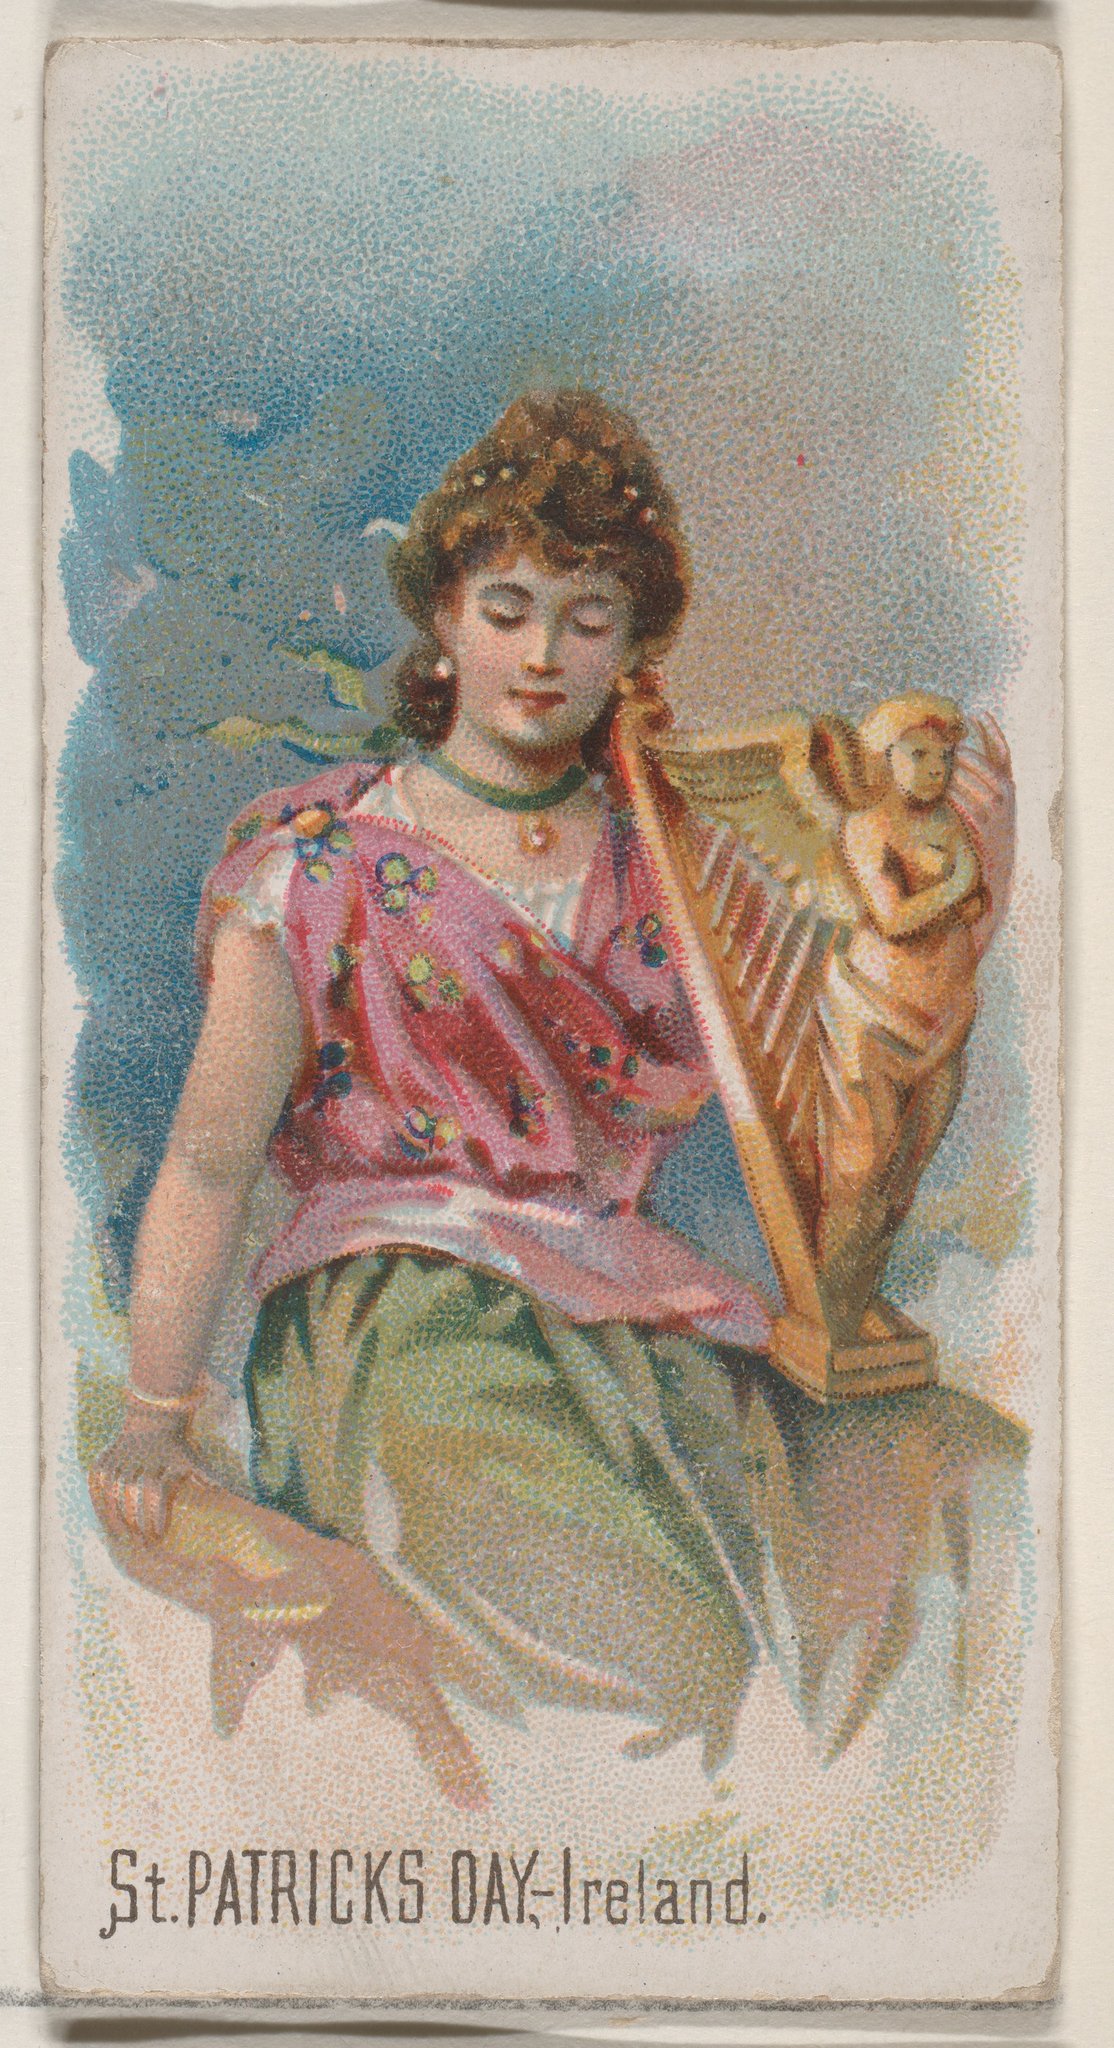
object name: print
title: St. Patrick's Day, Ireland, from the Holidays series (N80) for Duke brand cigarettes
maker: w. duke, sons & co.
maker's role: publisher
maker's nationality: american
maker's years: 1870-1920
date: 1890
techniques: color lithograph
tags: women